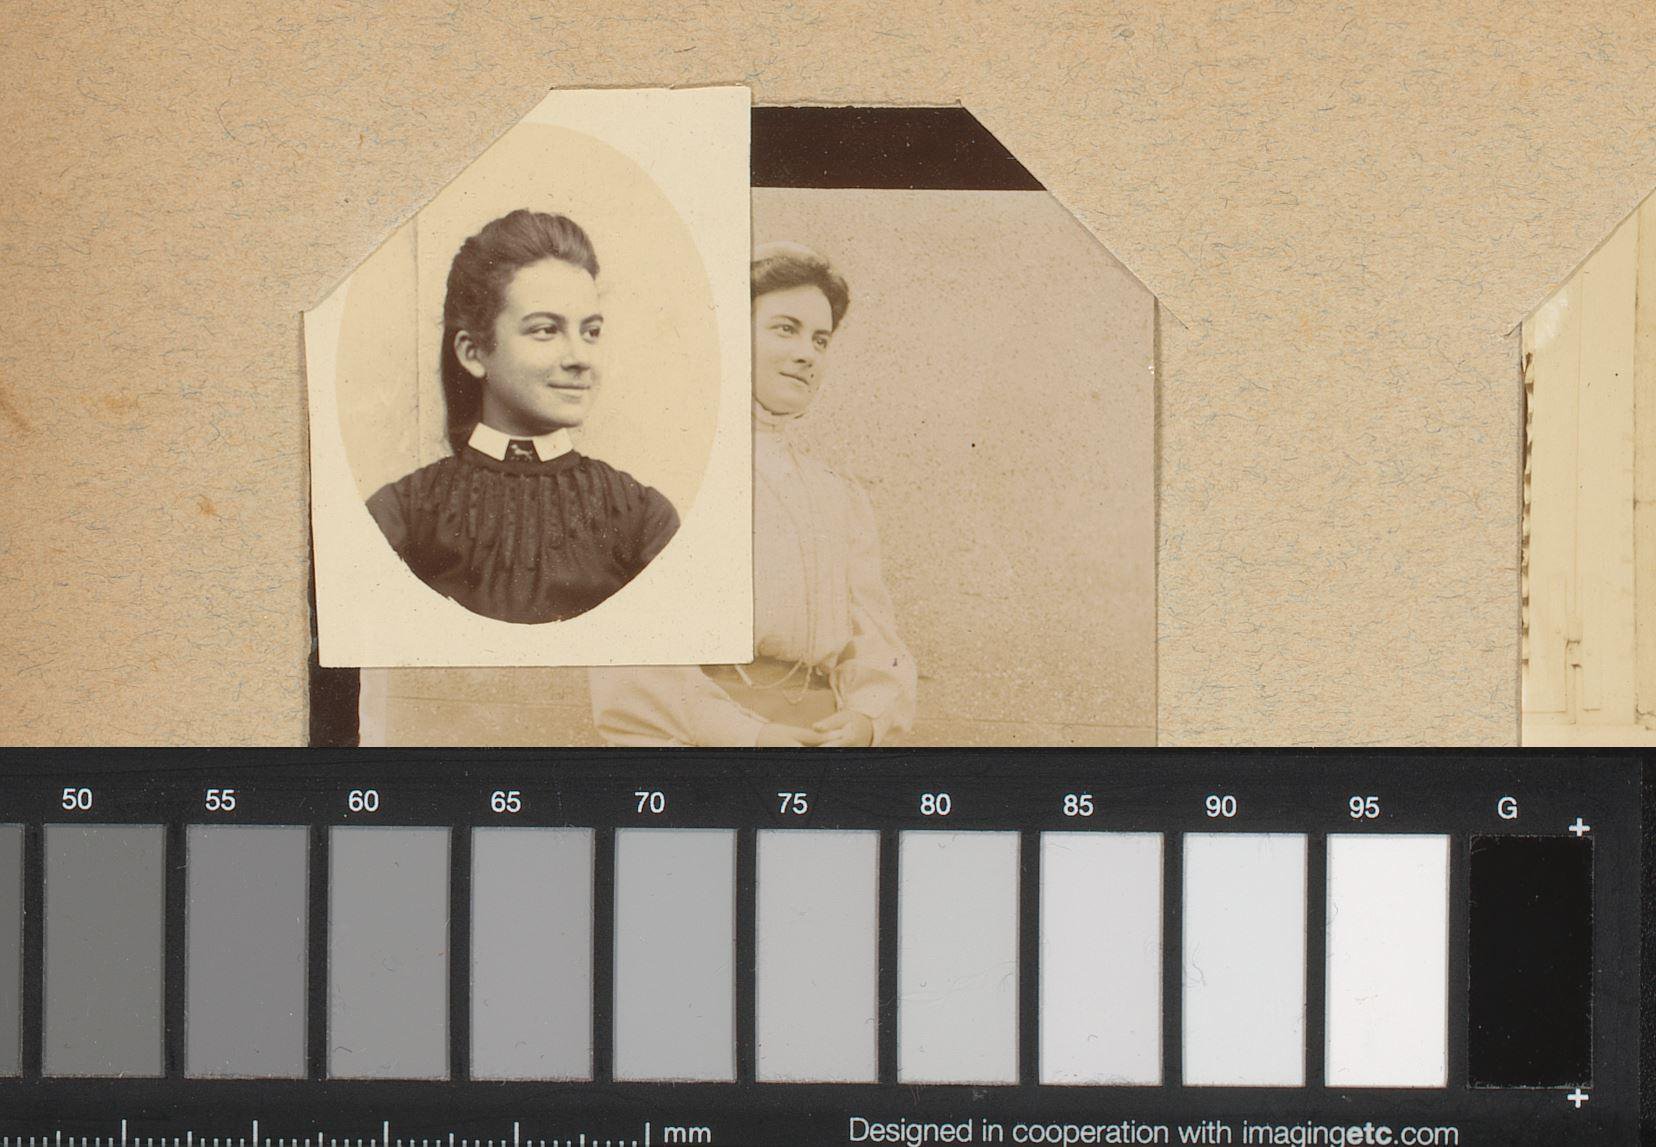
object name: album leaf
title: Portret van een jonge vrouw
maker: Anonymous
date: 1897-1900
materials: paper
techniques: gelatin silver print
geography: france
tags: adolescent, young woman, maiden, historical persons, france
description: Over de foto is een ander negatief afgedrukt van een voorstelling van bomen.